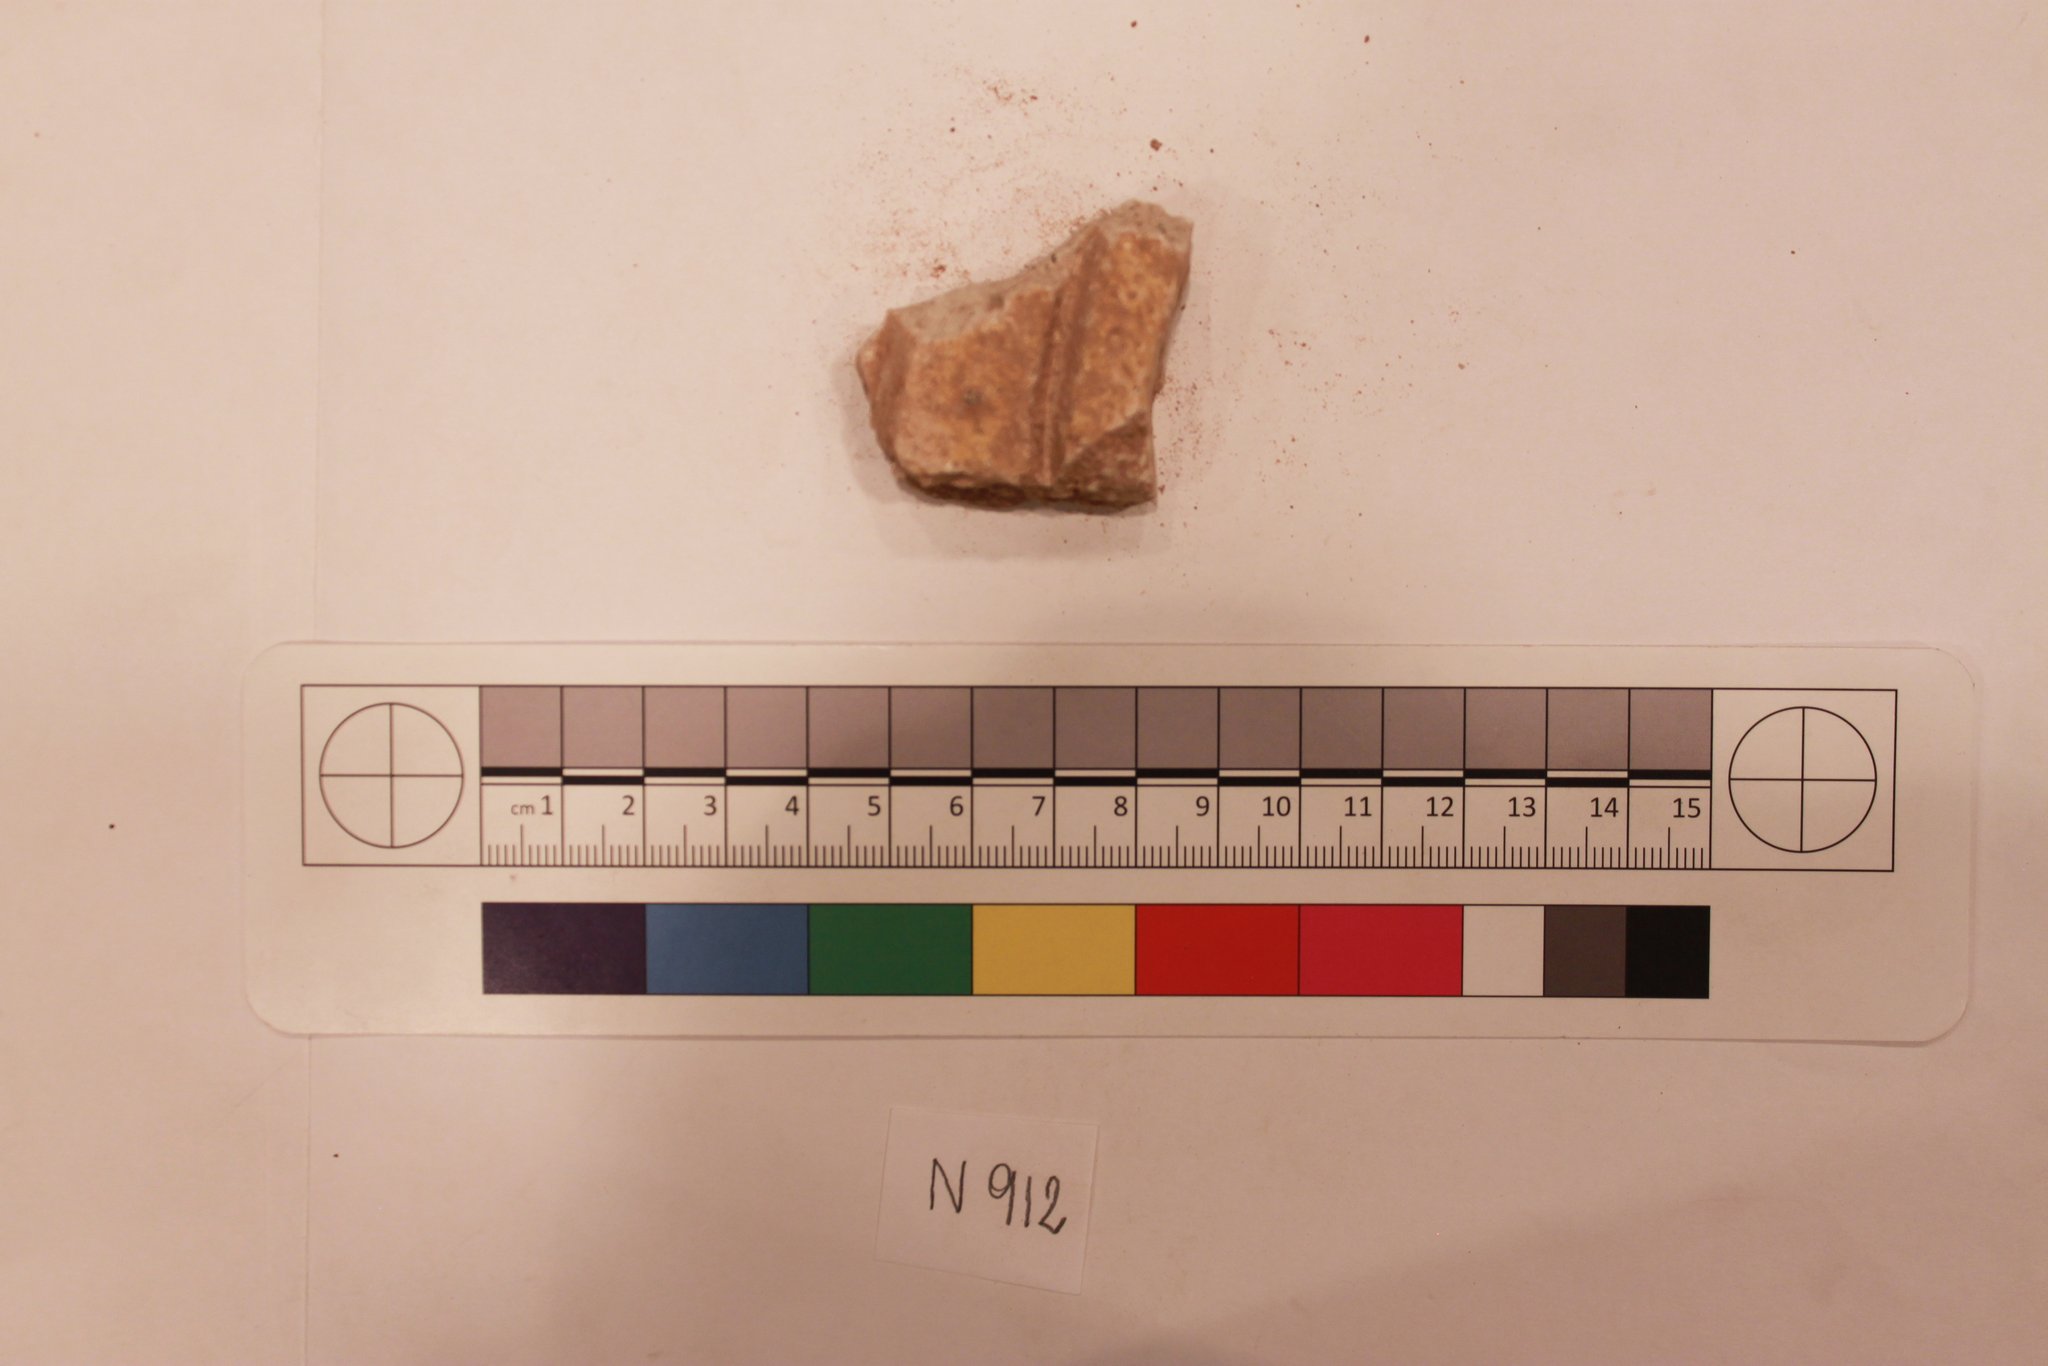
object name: fragment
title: Stucco Fragment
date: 701-1200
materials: plaster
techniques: carving, painting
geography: iran